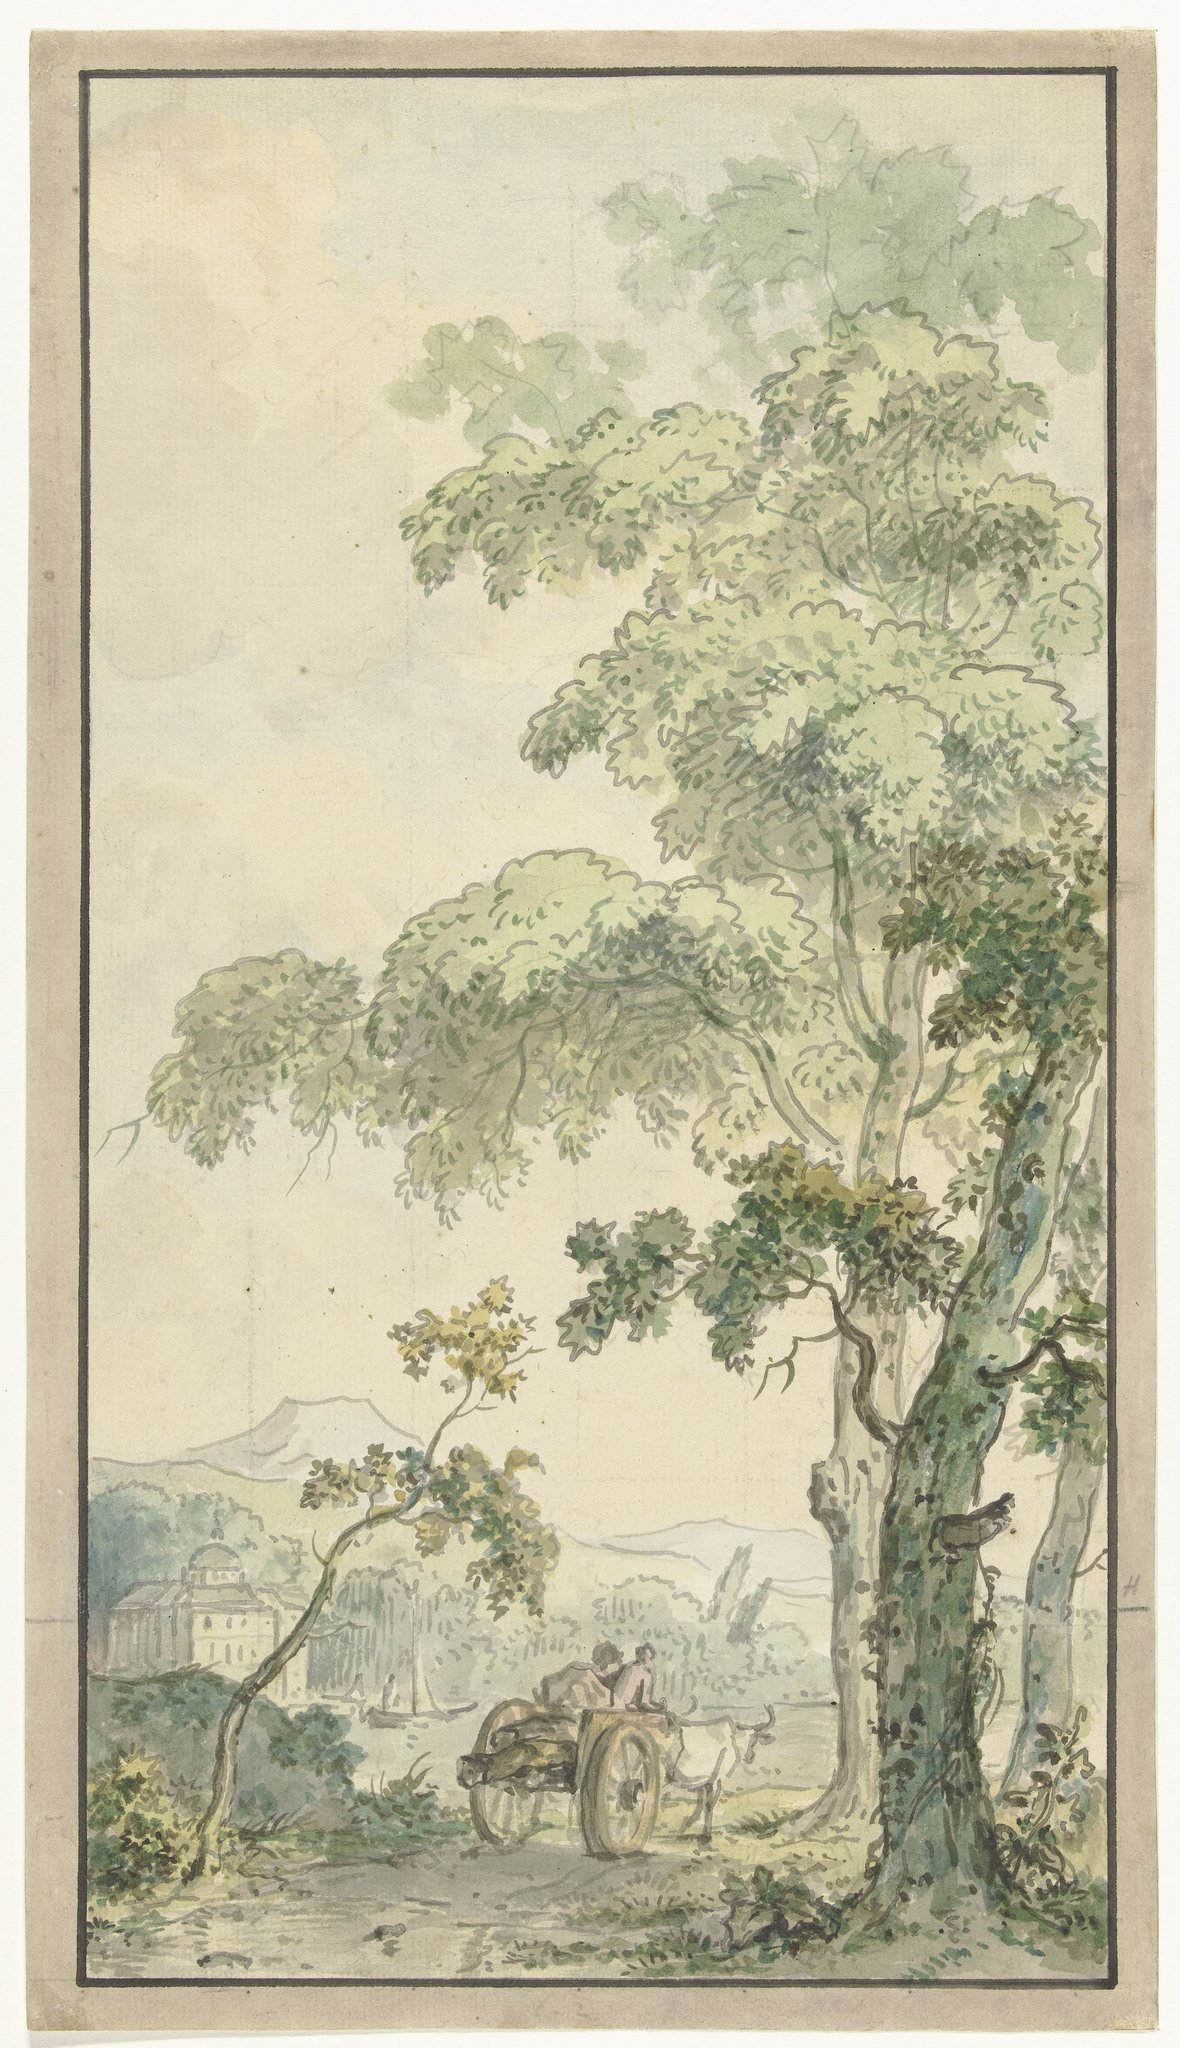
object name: design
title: Ontwerp voor kamerbehangsel met landschap met kar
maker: jurriaan andriessen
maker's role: draughtsman, painter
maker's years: 1742-1819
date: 1752-1819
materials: graphite, ink, paper, watercolor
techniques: brush, pen